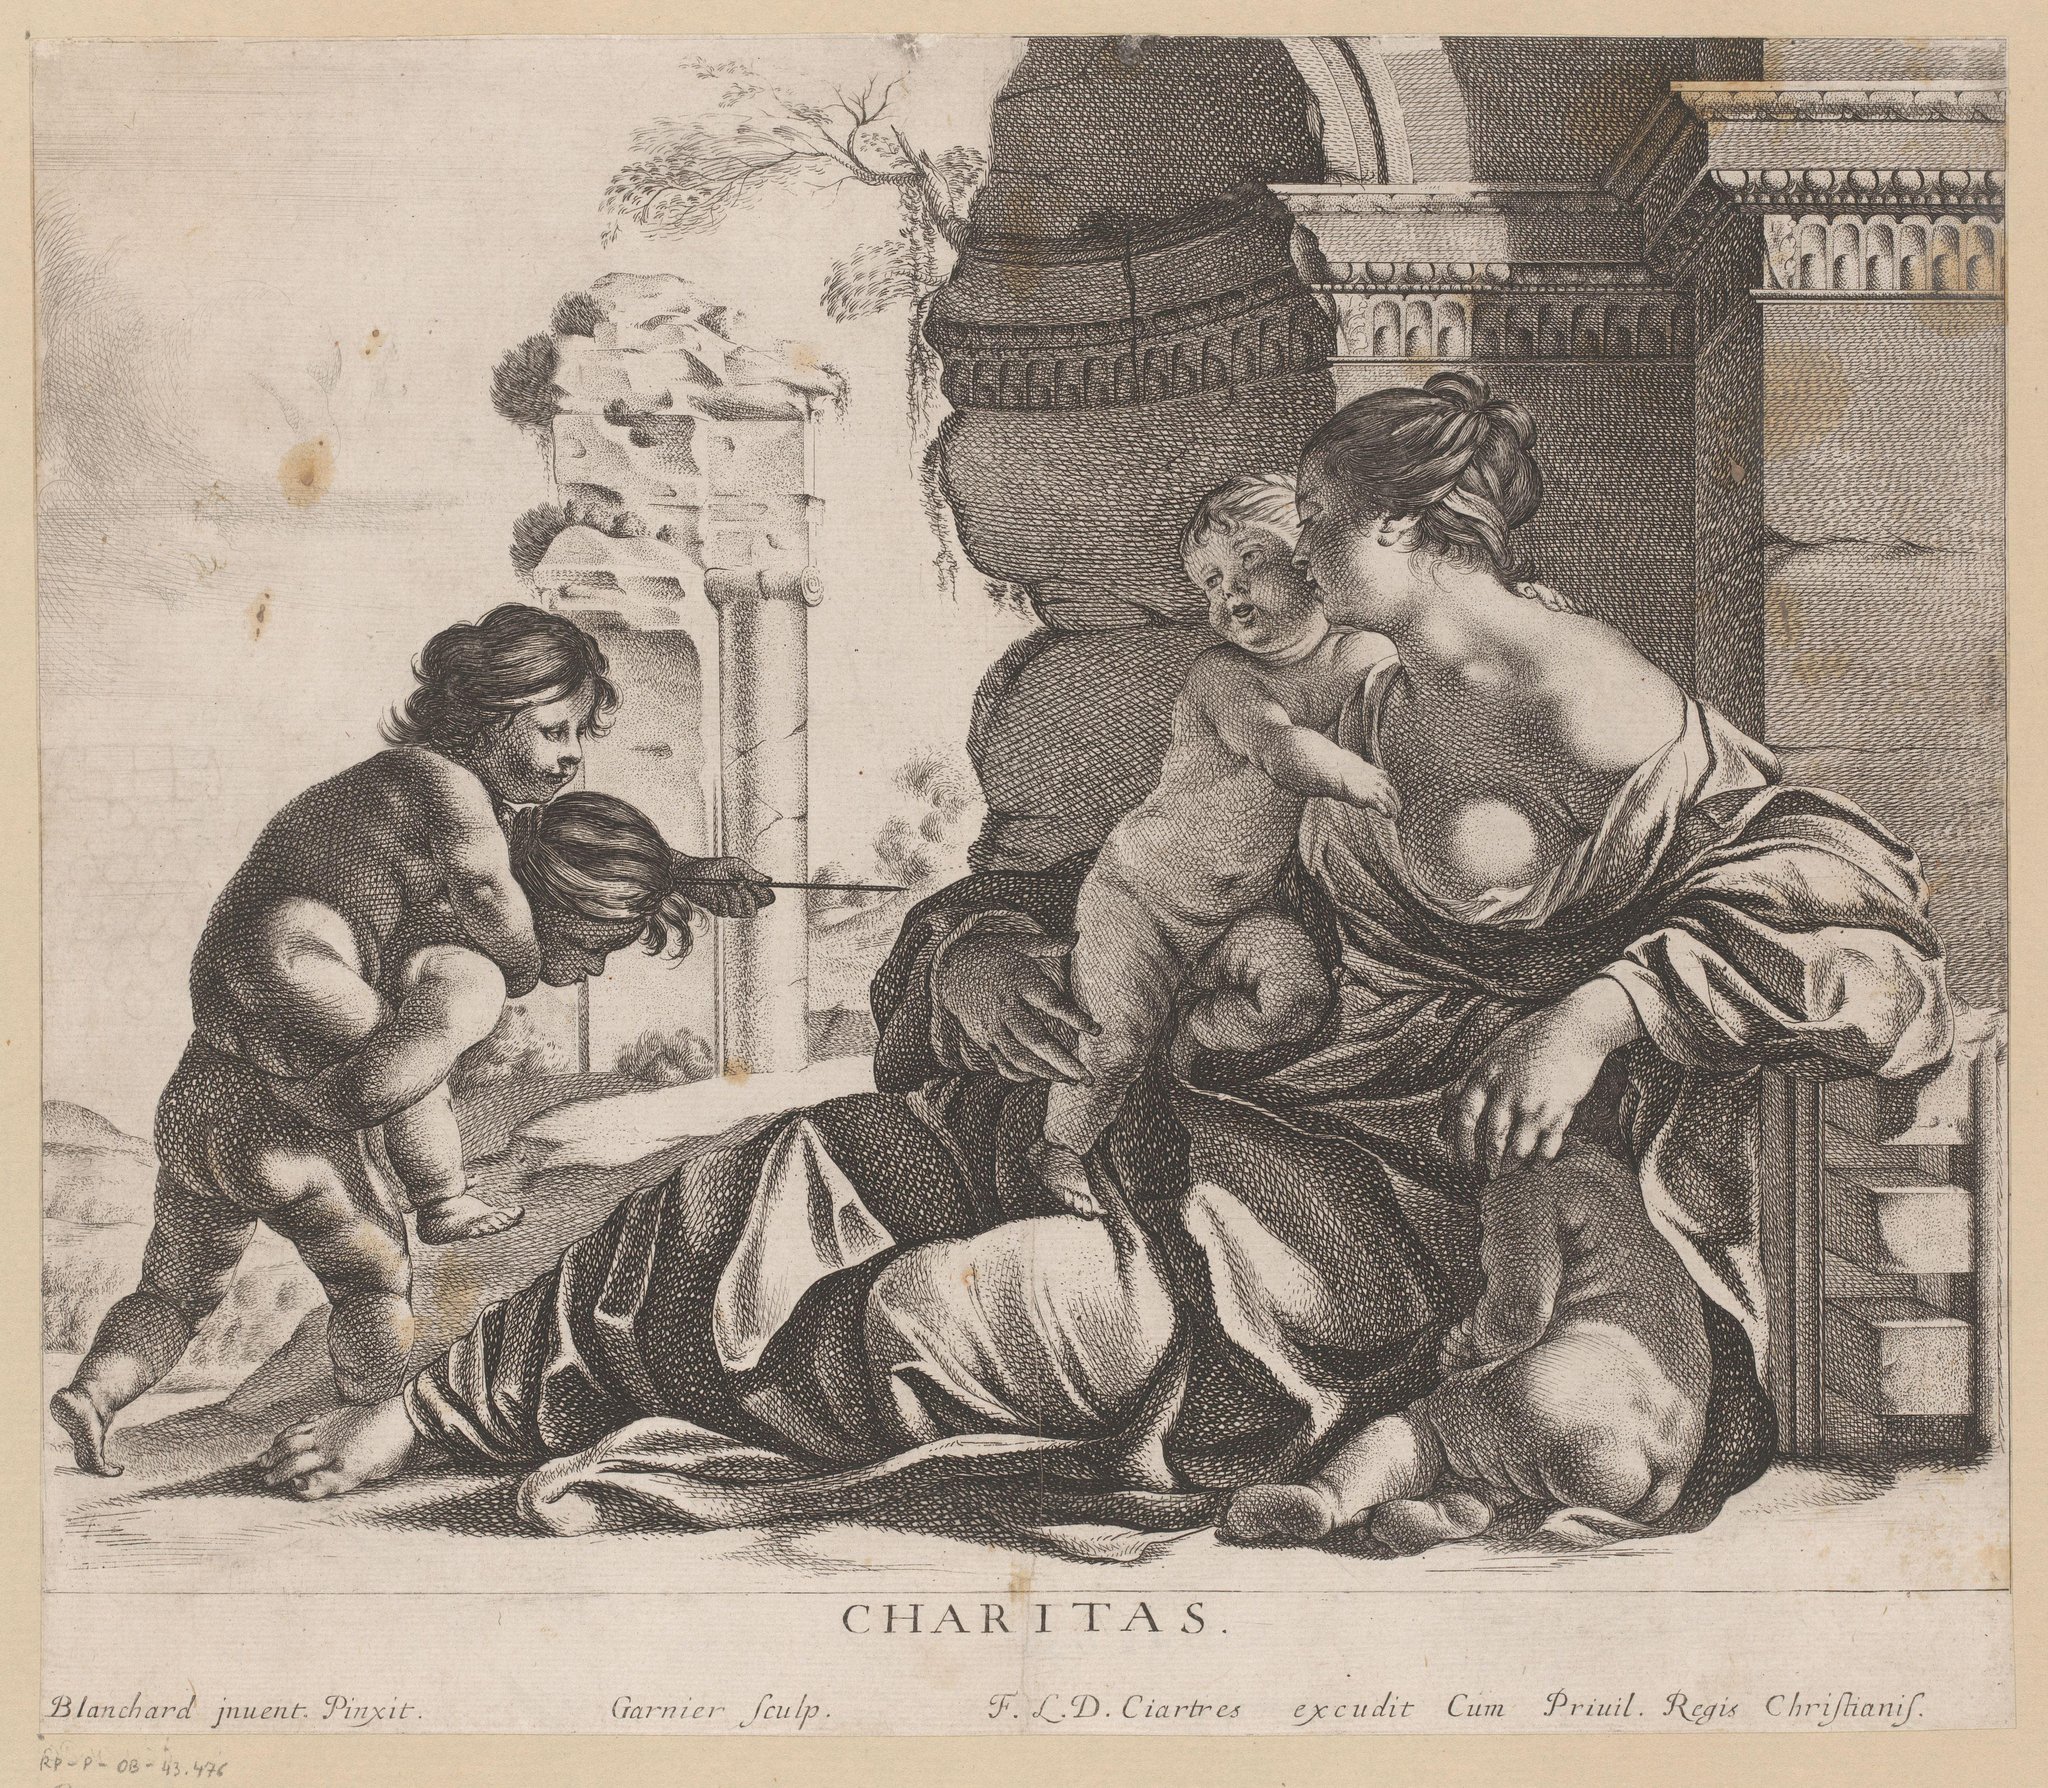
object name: print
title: Charitas.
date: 1621-1694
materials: paper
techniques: engraving, etching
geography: france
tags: charity, 'caritas'; 'carità' (ripa) ~ one of the three theological virtues, children's games and plays, ruin of a building ~ architecture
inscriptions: collector's mark: Lugt 240